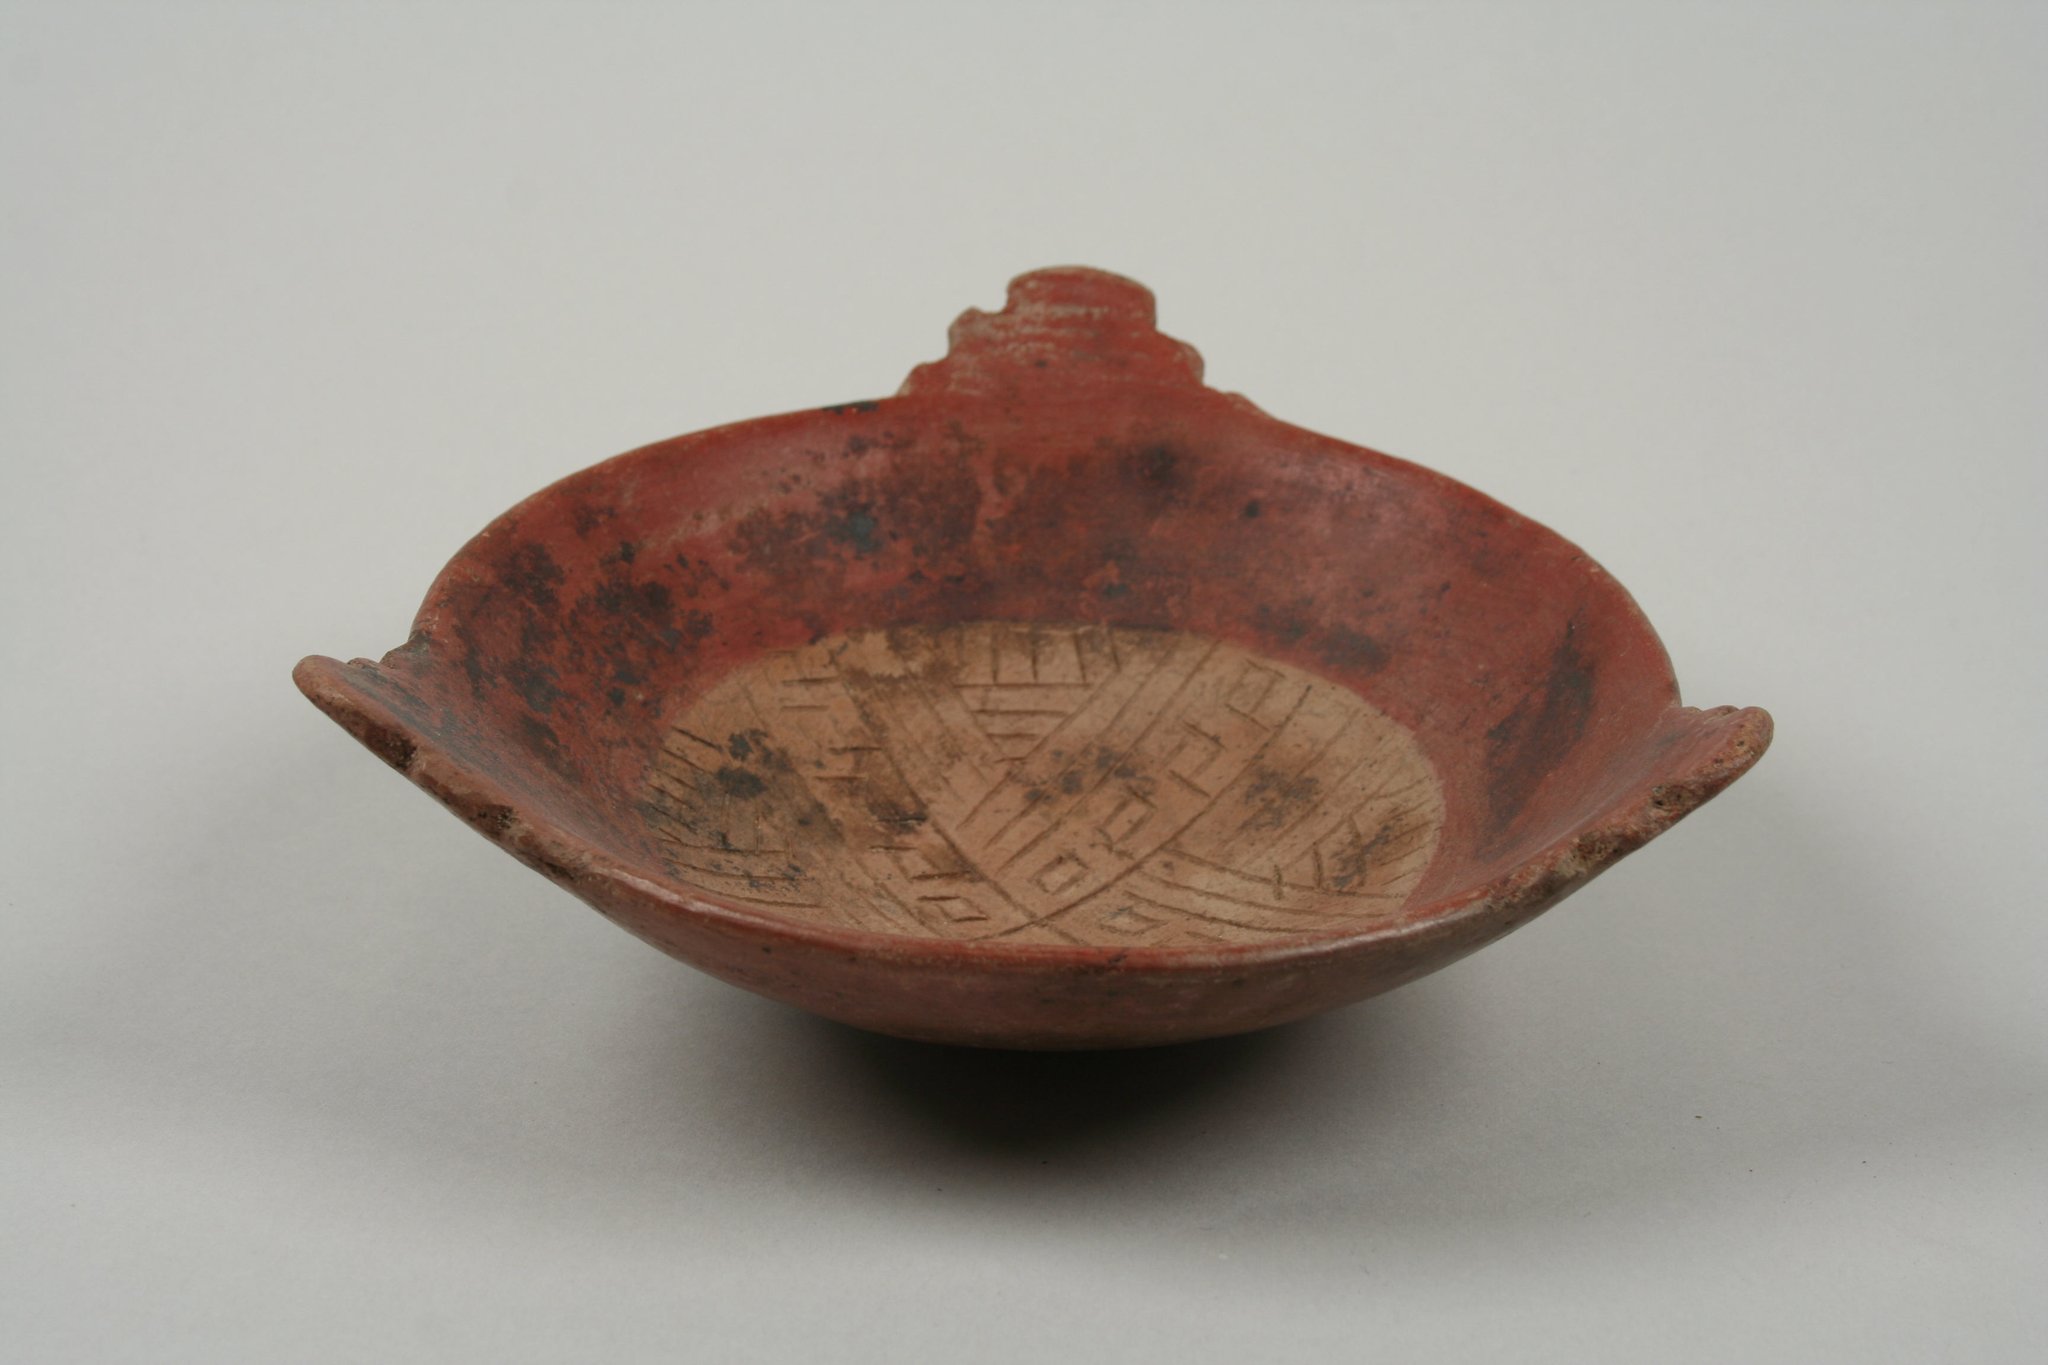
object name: bowl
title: Bowl with Three Lugs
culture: paracas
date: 700-301 BCE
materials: ceramic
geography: peru